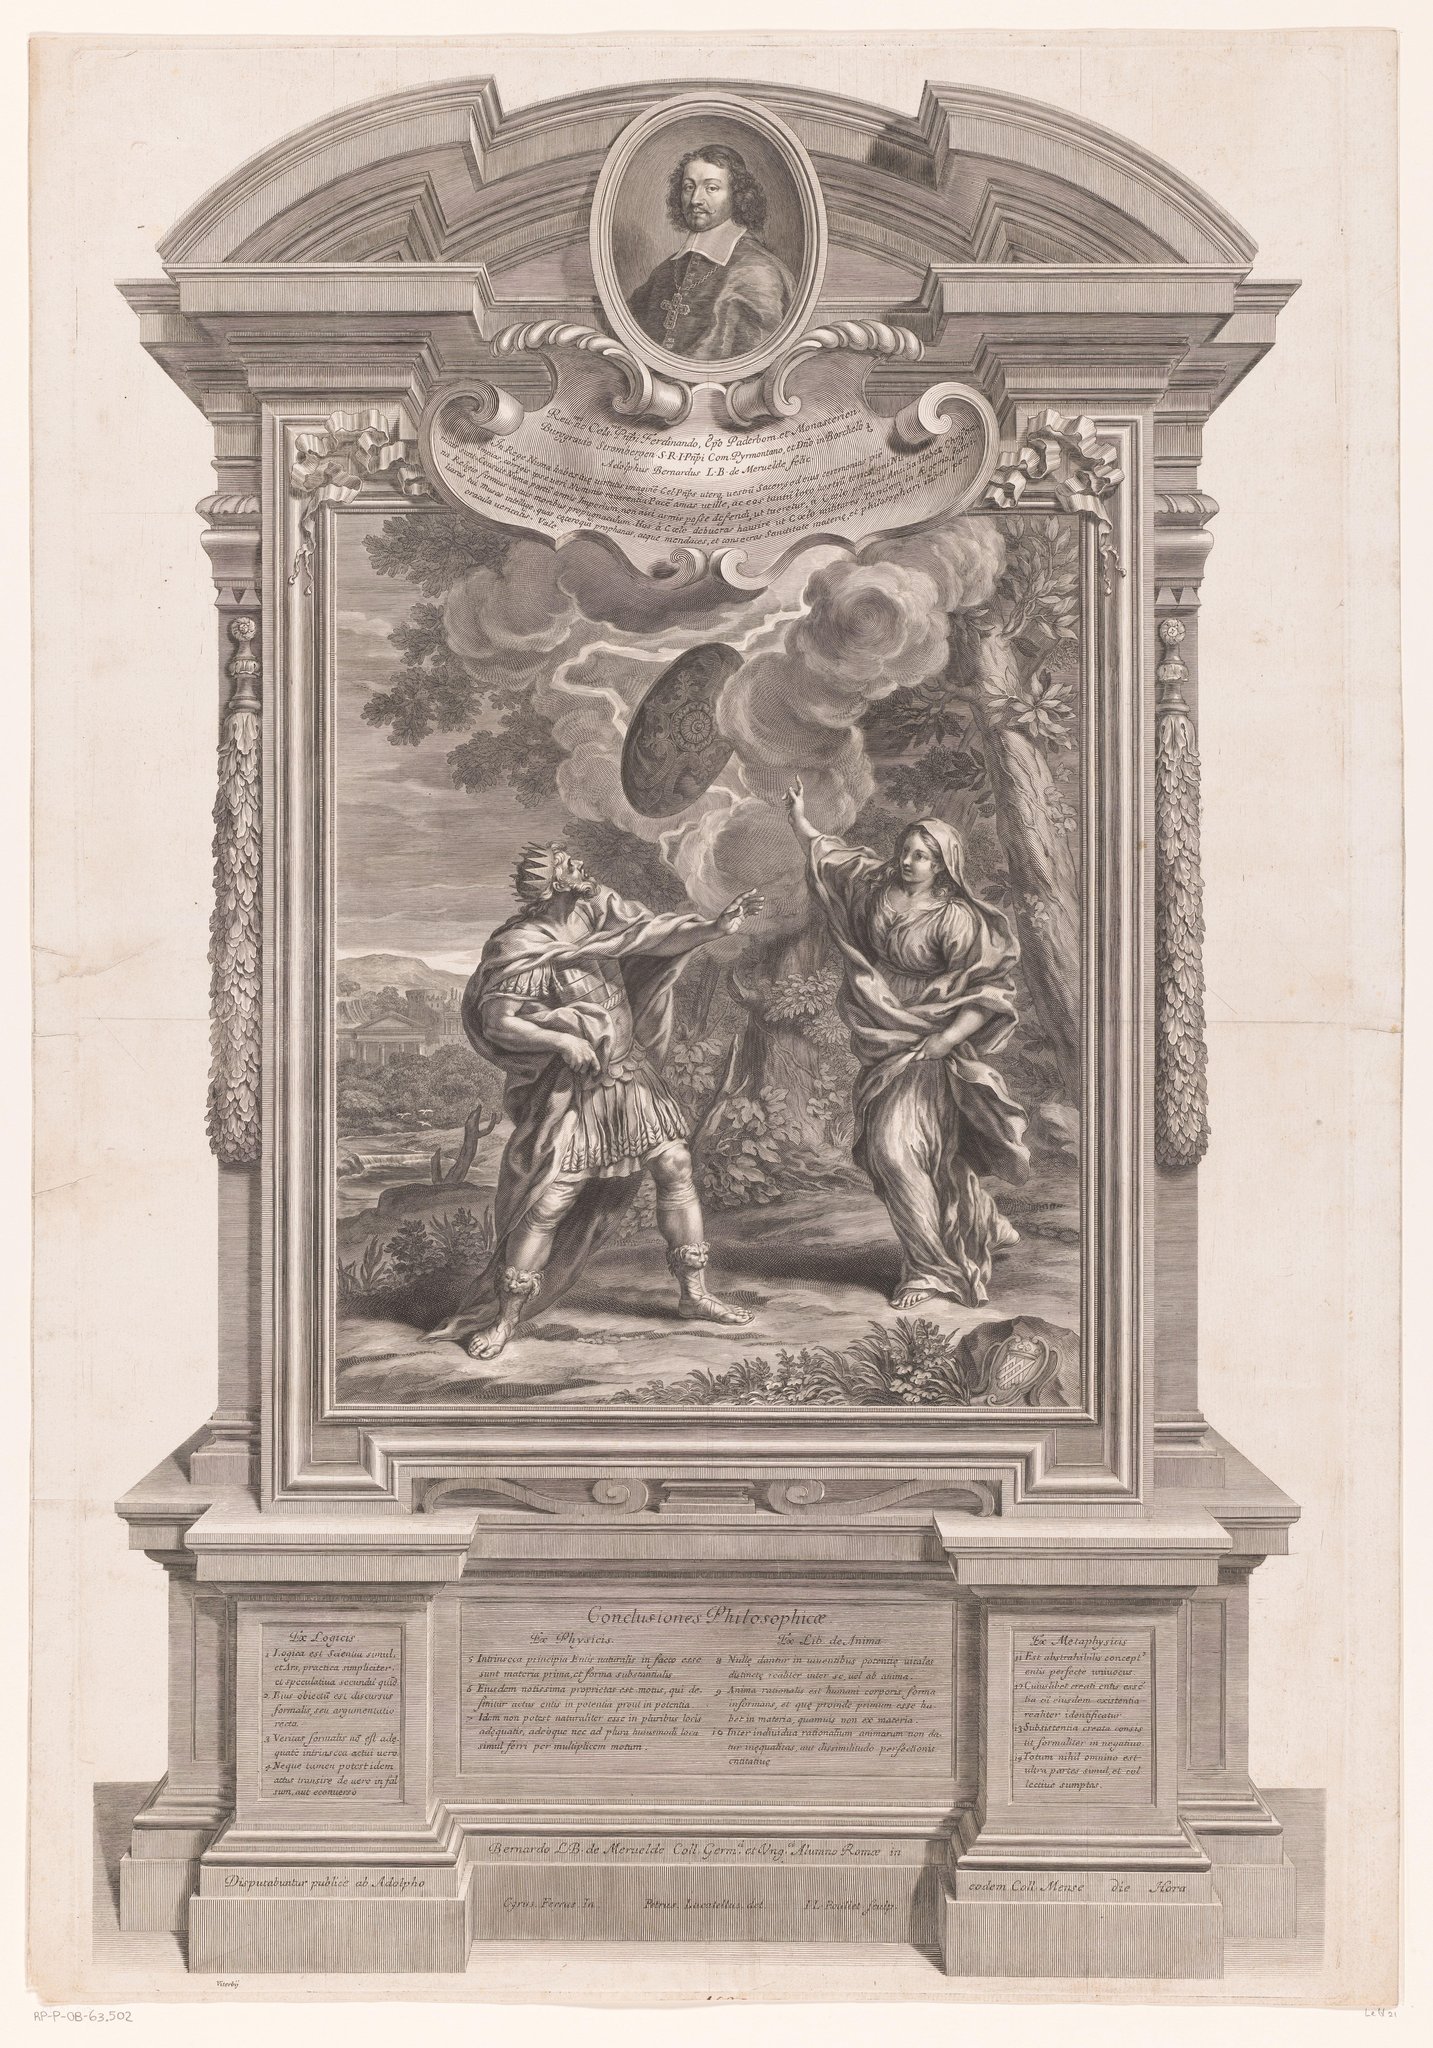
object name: print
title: Koning Numa ontvangt het heilige schild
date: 1655-1699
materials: paper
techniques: engraving, etching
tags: (story of) numa pompilius, philosophy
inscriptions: collector's mark: Lugt 240